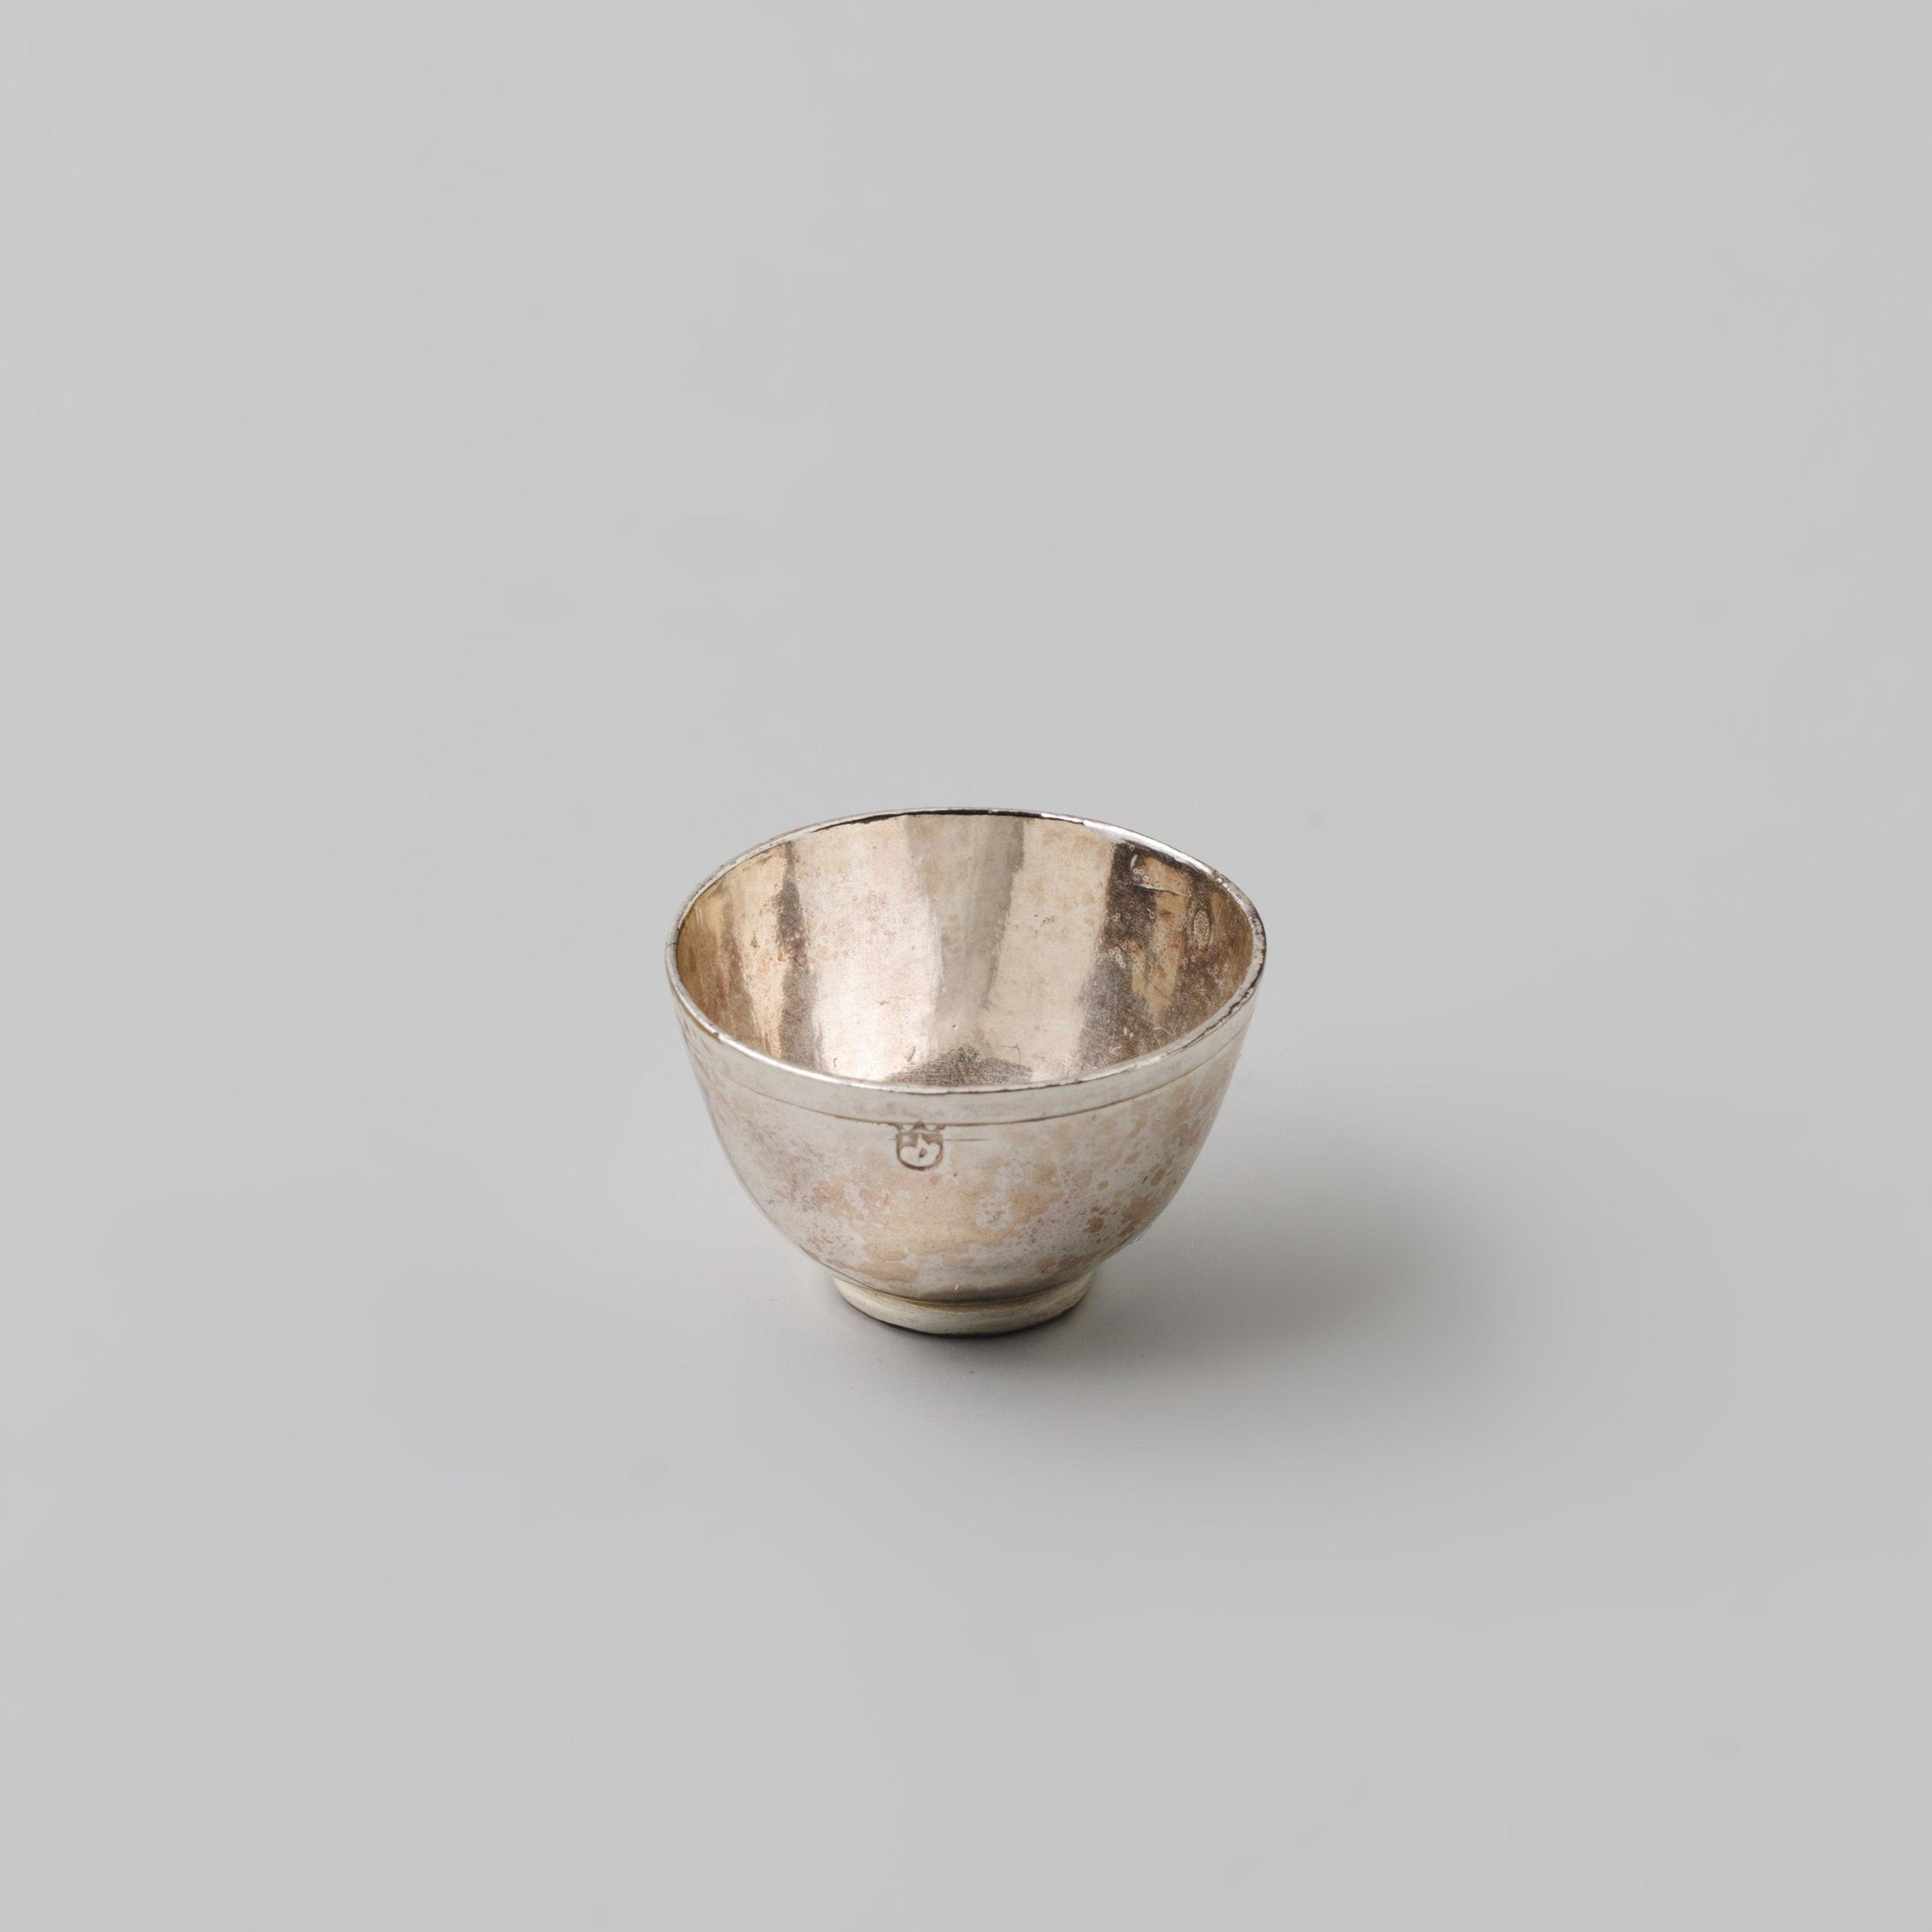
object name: miniature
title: Schotel van zilver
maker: Anonymous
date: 1800-1899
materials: silver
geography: hoorn